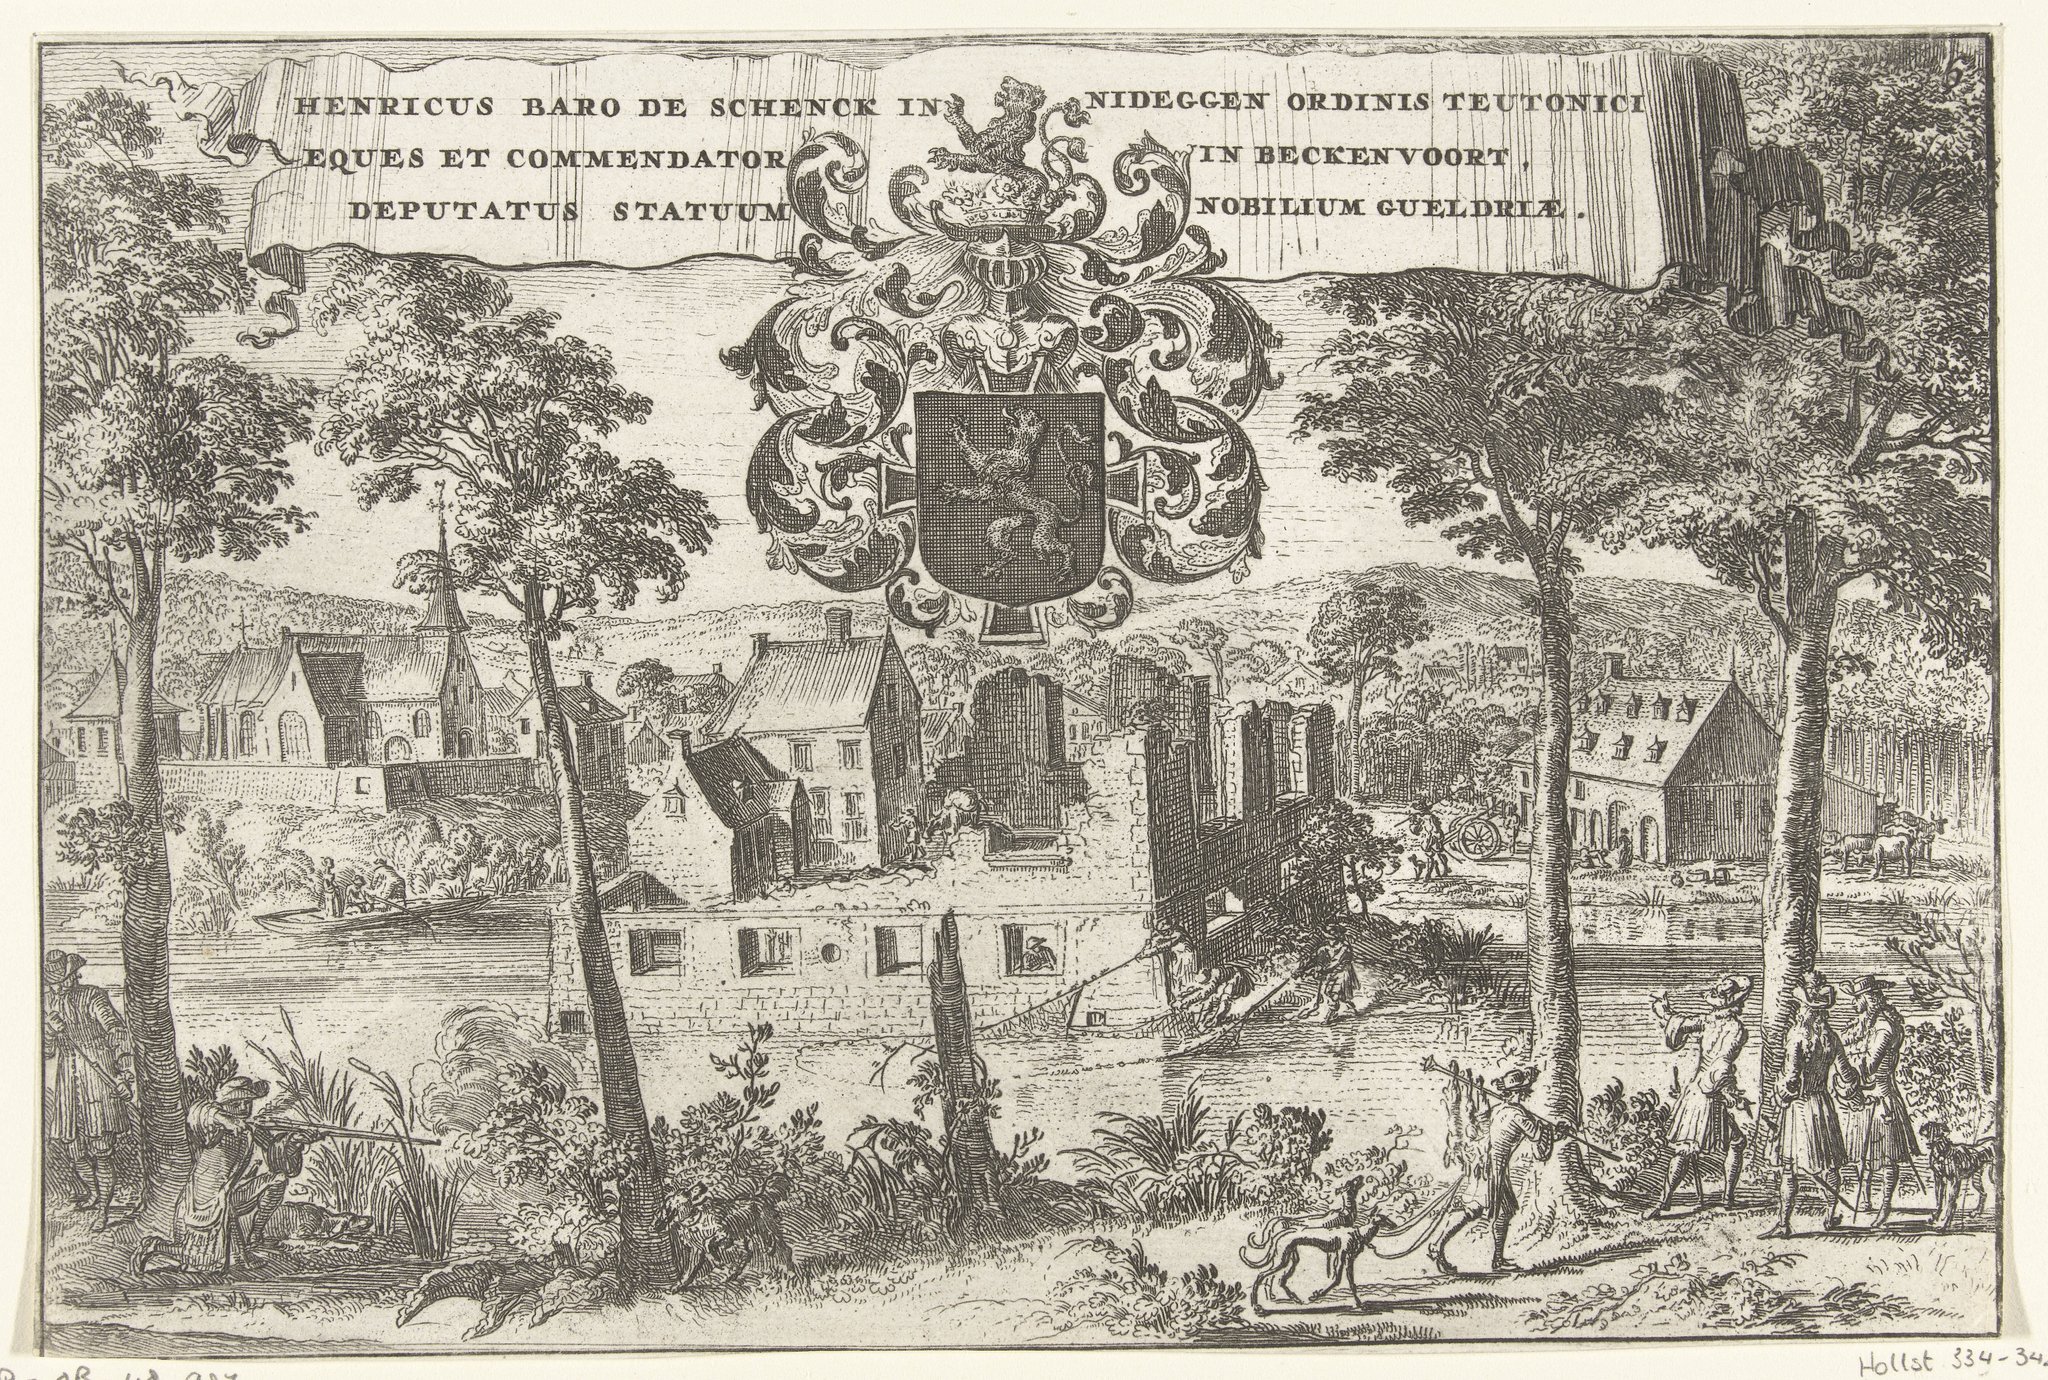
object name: print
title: Verheerlijking van de Duitse Orde, in het bijzonder van de landcommanderij Alden Biesen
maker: romeyn de hooghe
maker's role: draughtsman, goldsmith, painter, print maker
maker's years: 1645-1708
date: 1700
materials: paper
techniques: etching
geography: haarlem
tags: castle, military orders, e.g.: knights templars, knights of malta, teutonic knights ~ roman catholic church, armorial bearing, heraldry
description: Gezicht op kasteel Bekkevoort bij Diest. Bovenin de voorstelling een banderol met Latijnse tekst en een wapen. Deze prent maakt deel uit van een omvangrijke voorstelling, samengesteld uit 20 afzonderlijke platen, van de geschiedenis en de werken van de Duitse Orde (midden) omgeven door voorstellingen van de landcommanderij Alden Biesen (onderaan) en de daarbij behorende commanderijen (links en rechts).